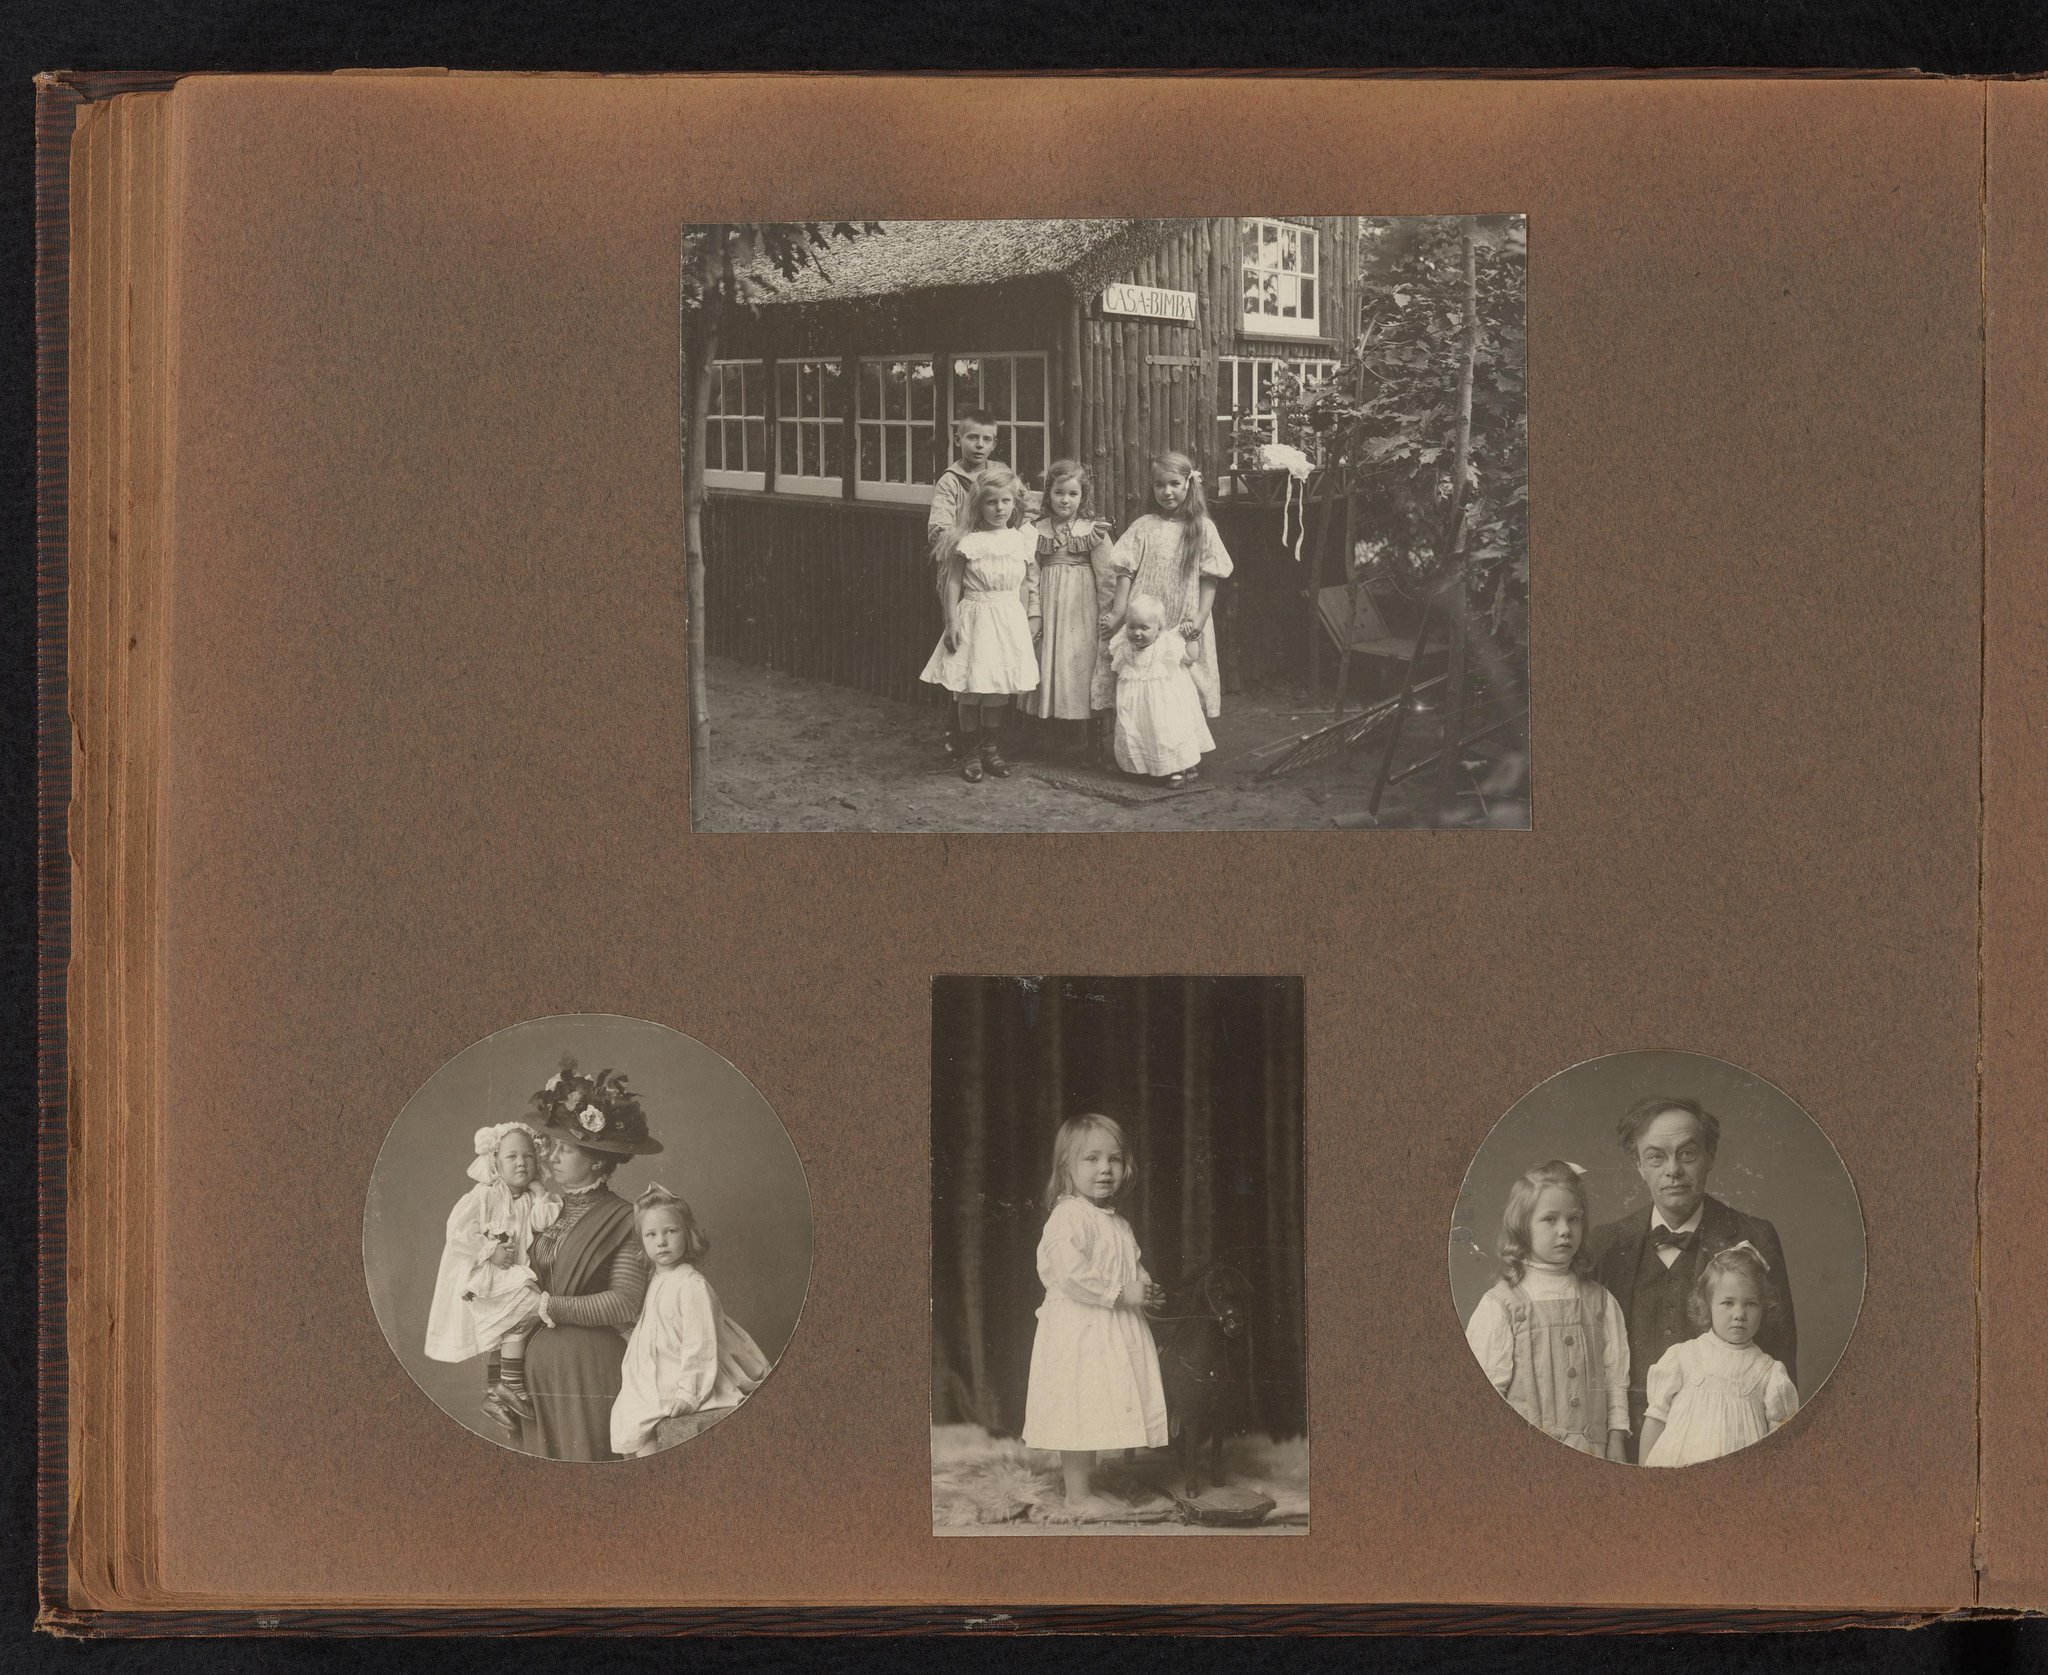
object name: photograph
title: Bladzijde uit het fotoalbum van de familie Diepenbrock met 4 foto's van Alphons Diepenbrock en zijn omgeving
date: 1909-1920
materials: cardboard, photographic support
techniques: photography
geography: amsterdam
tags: amsterdam, alphons diepenbrock, netherlands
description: Bruin albumblad 44 van familiealbum van Alphons Diepenbrock.